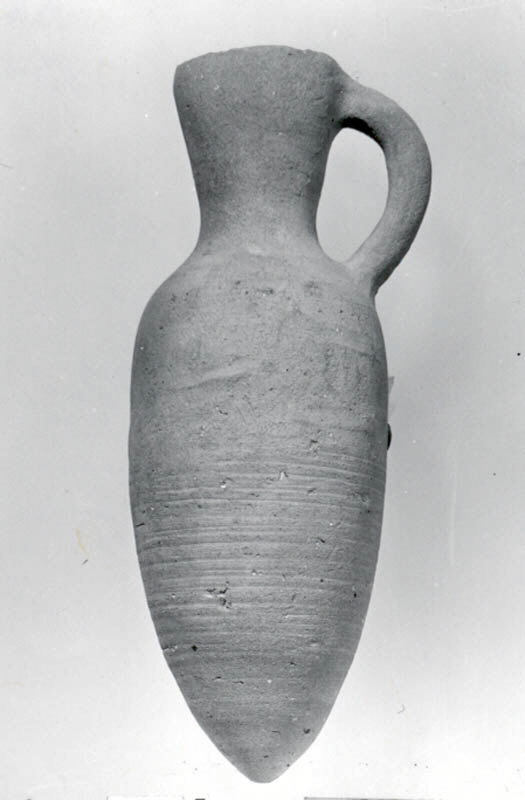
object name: jug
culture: canaanite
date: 1780-1580 BCE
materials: ceramic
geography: levant